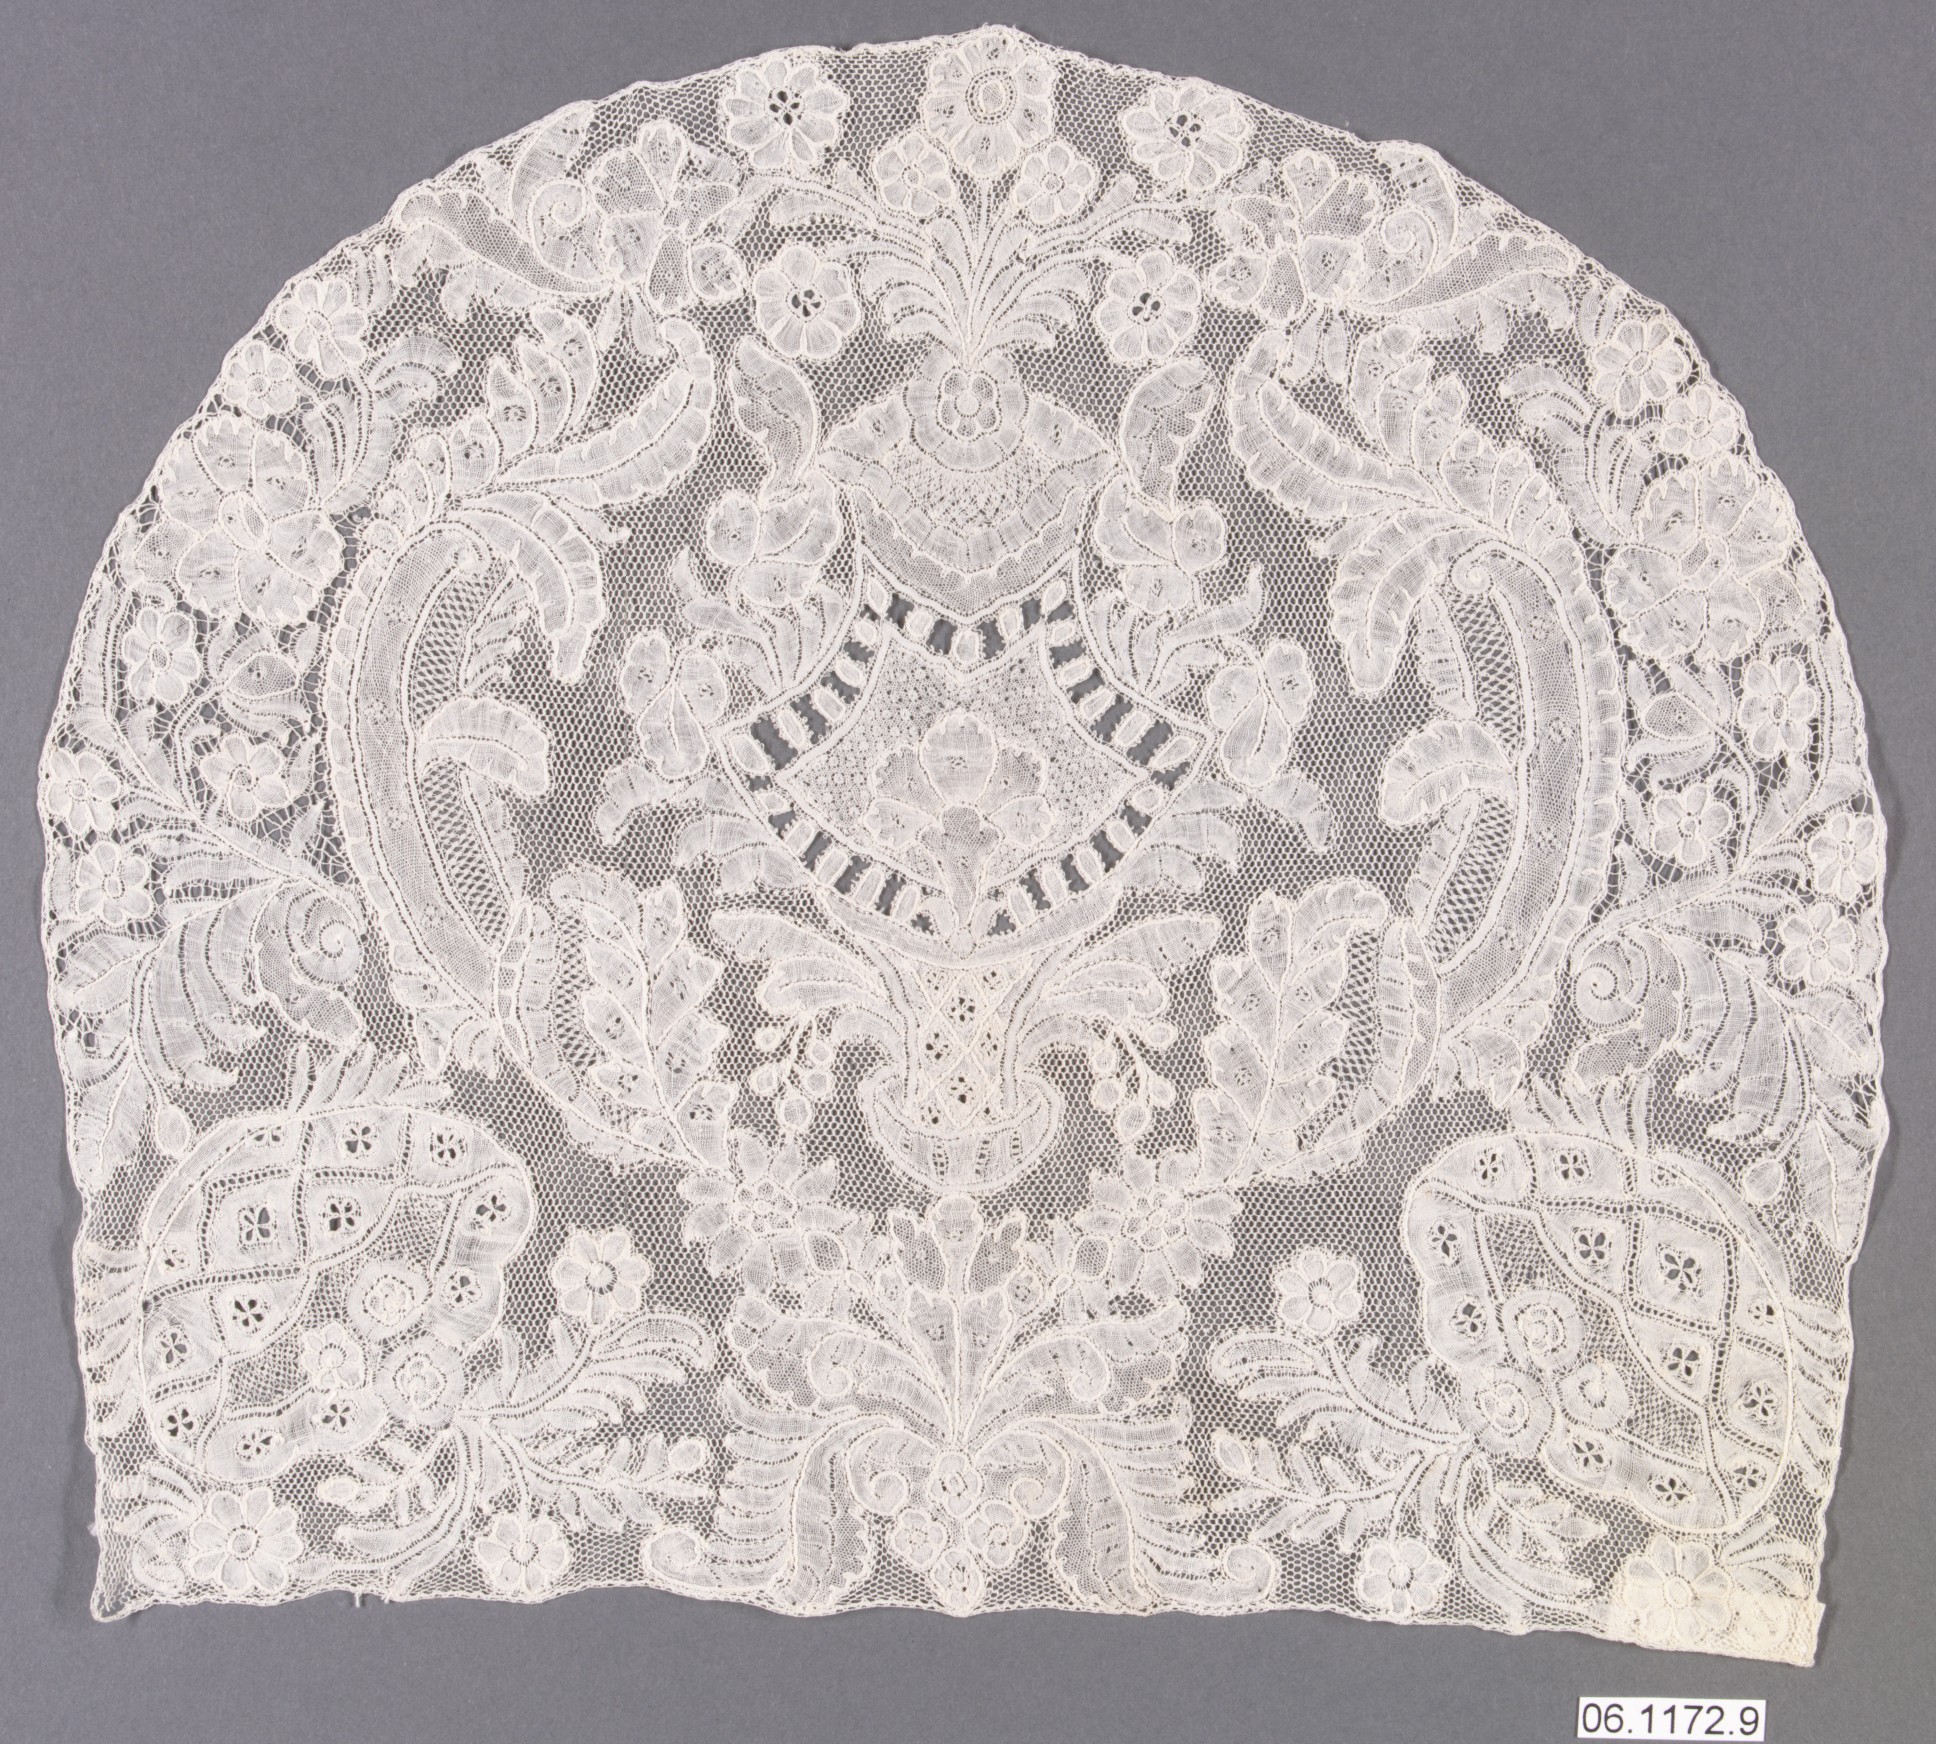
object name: cap crown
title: Cap crown (fond de bonnet)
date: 1701-1733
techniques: lace